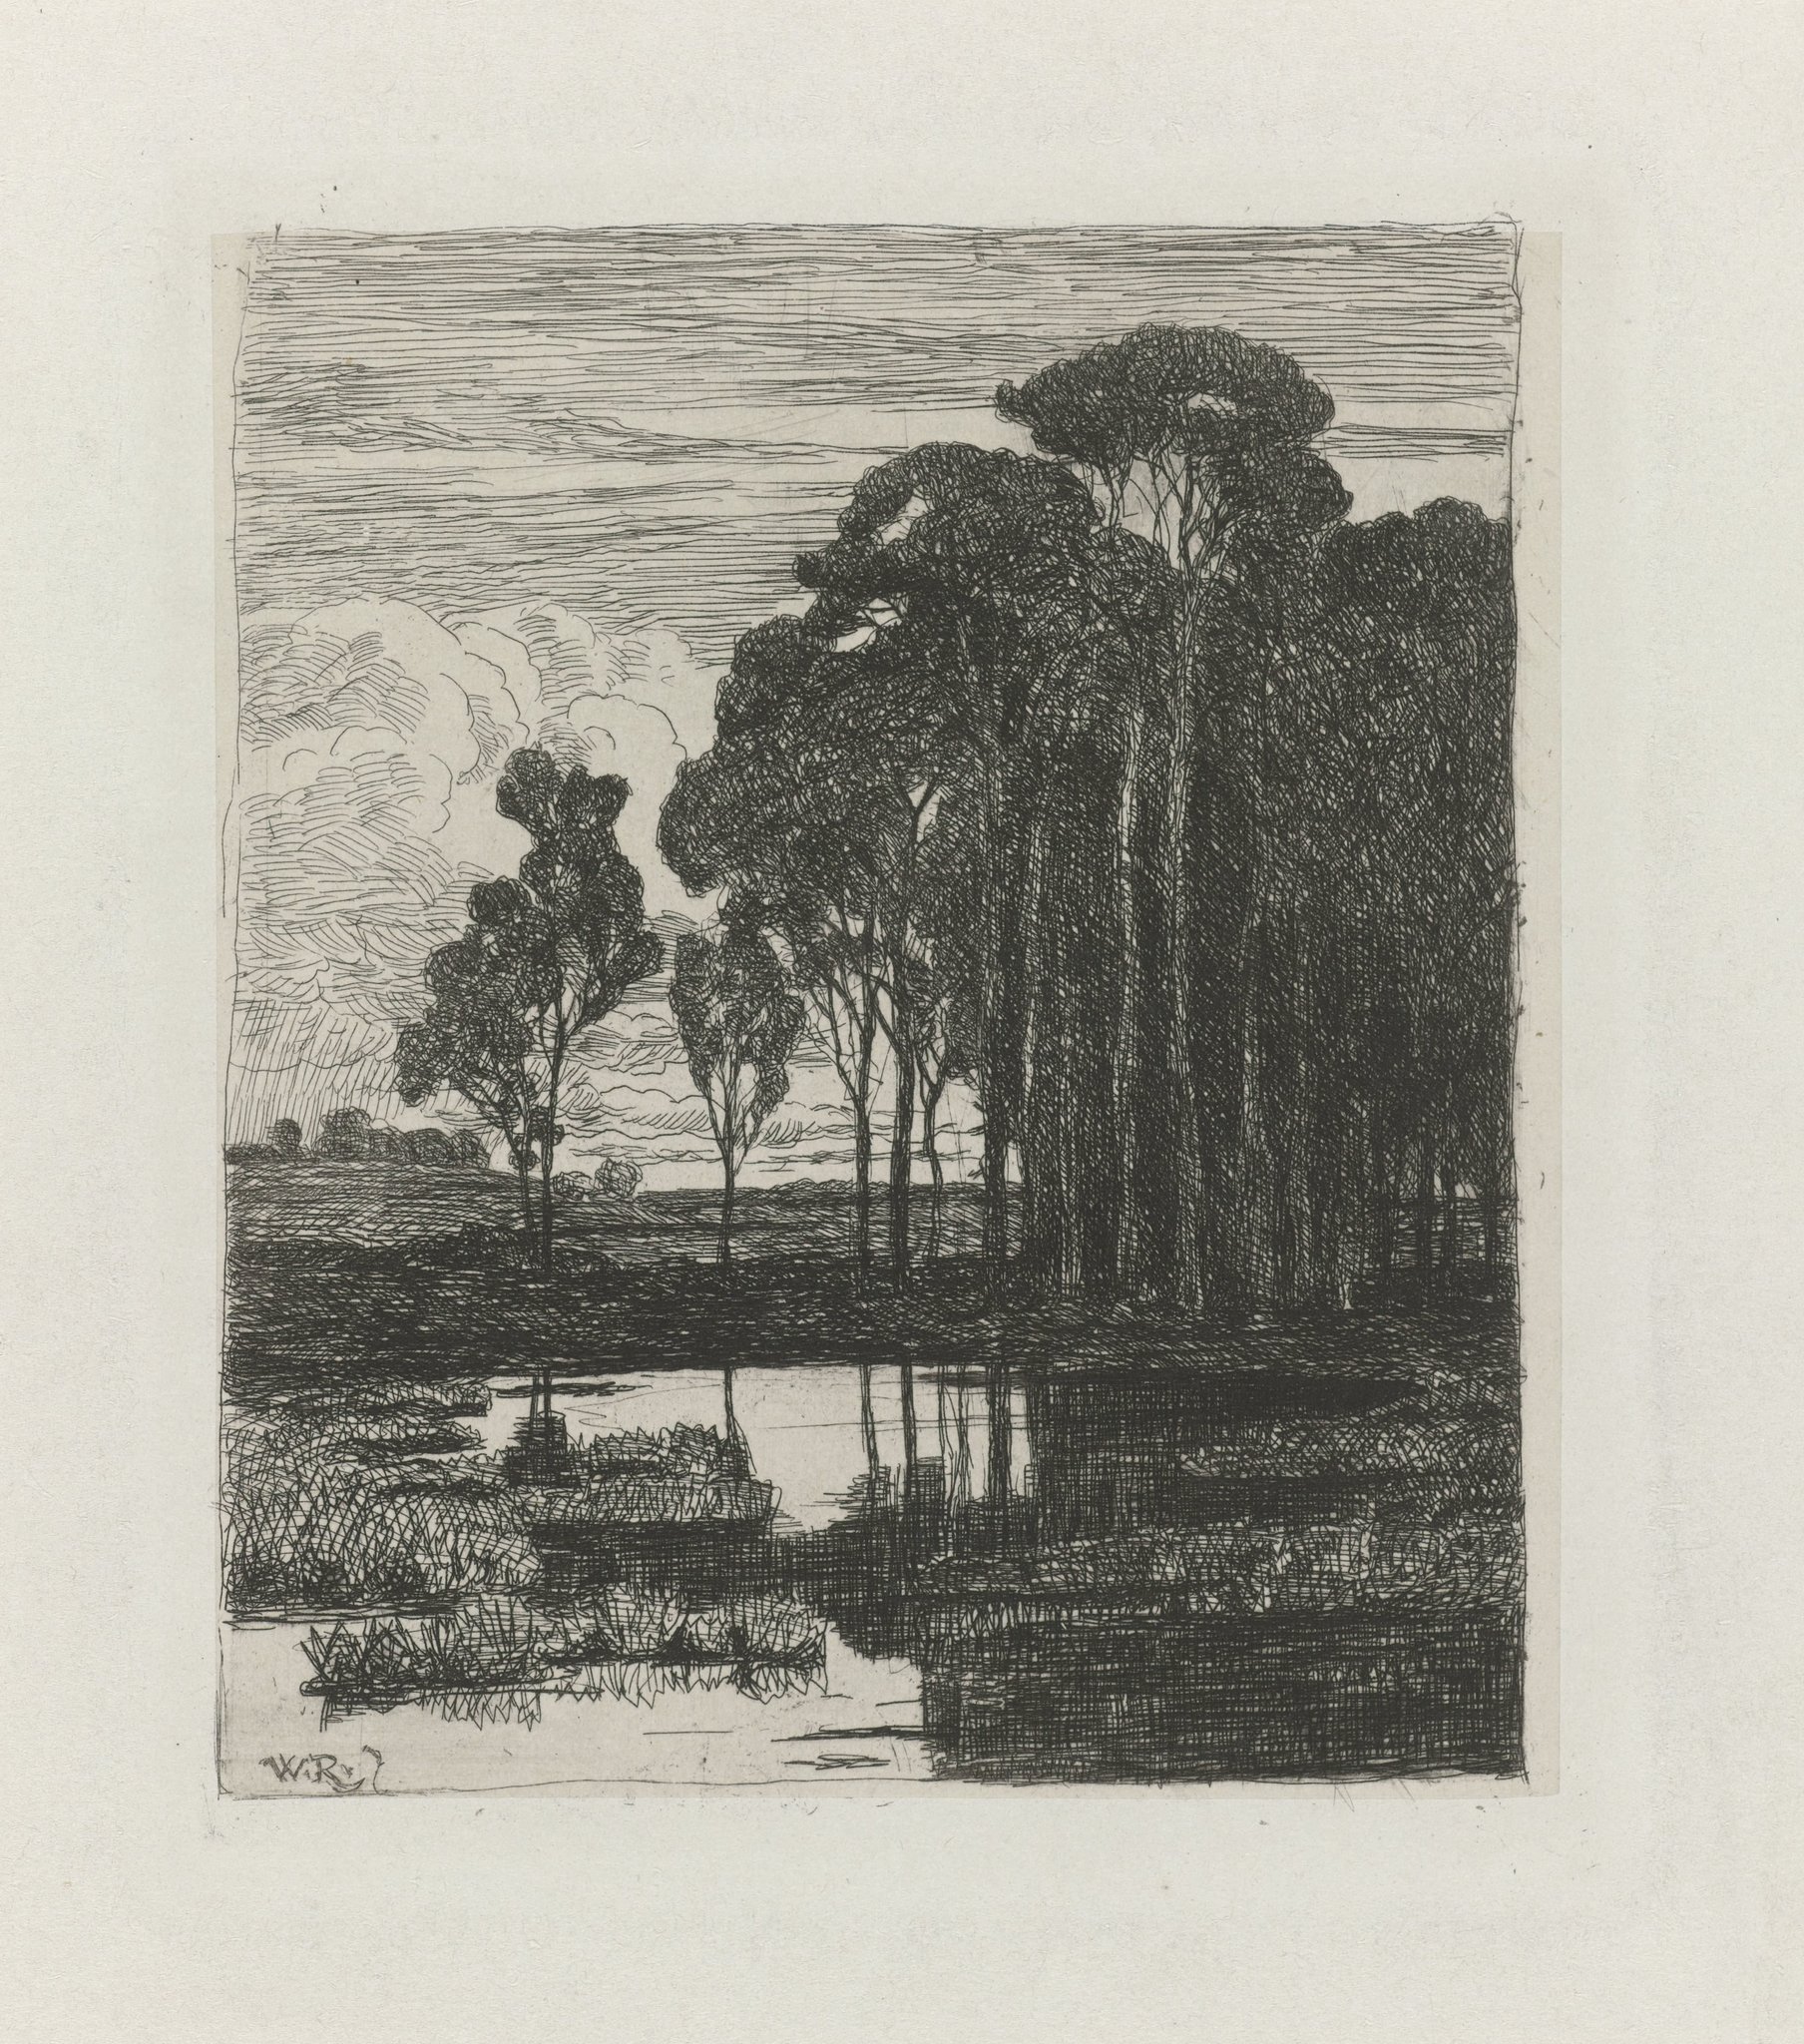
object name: print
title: Populieren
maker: willem roelofs (i)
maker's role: draughtsman, painter, print maker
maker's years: 1822-1897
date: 1832-1893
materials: paper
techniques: drypoint, etching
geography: netherlands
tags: landscapes, trees: poplar, pond, pool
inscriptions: collector's mark: Lugt 2228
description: Landschap met enkele populieren aan de rand van een waterplas. In het water is een reflectie van de bomen te zien.